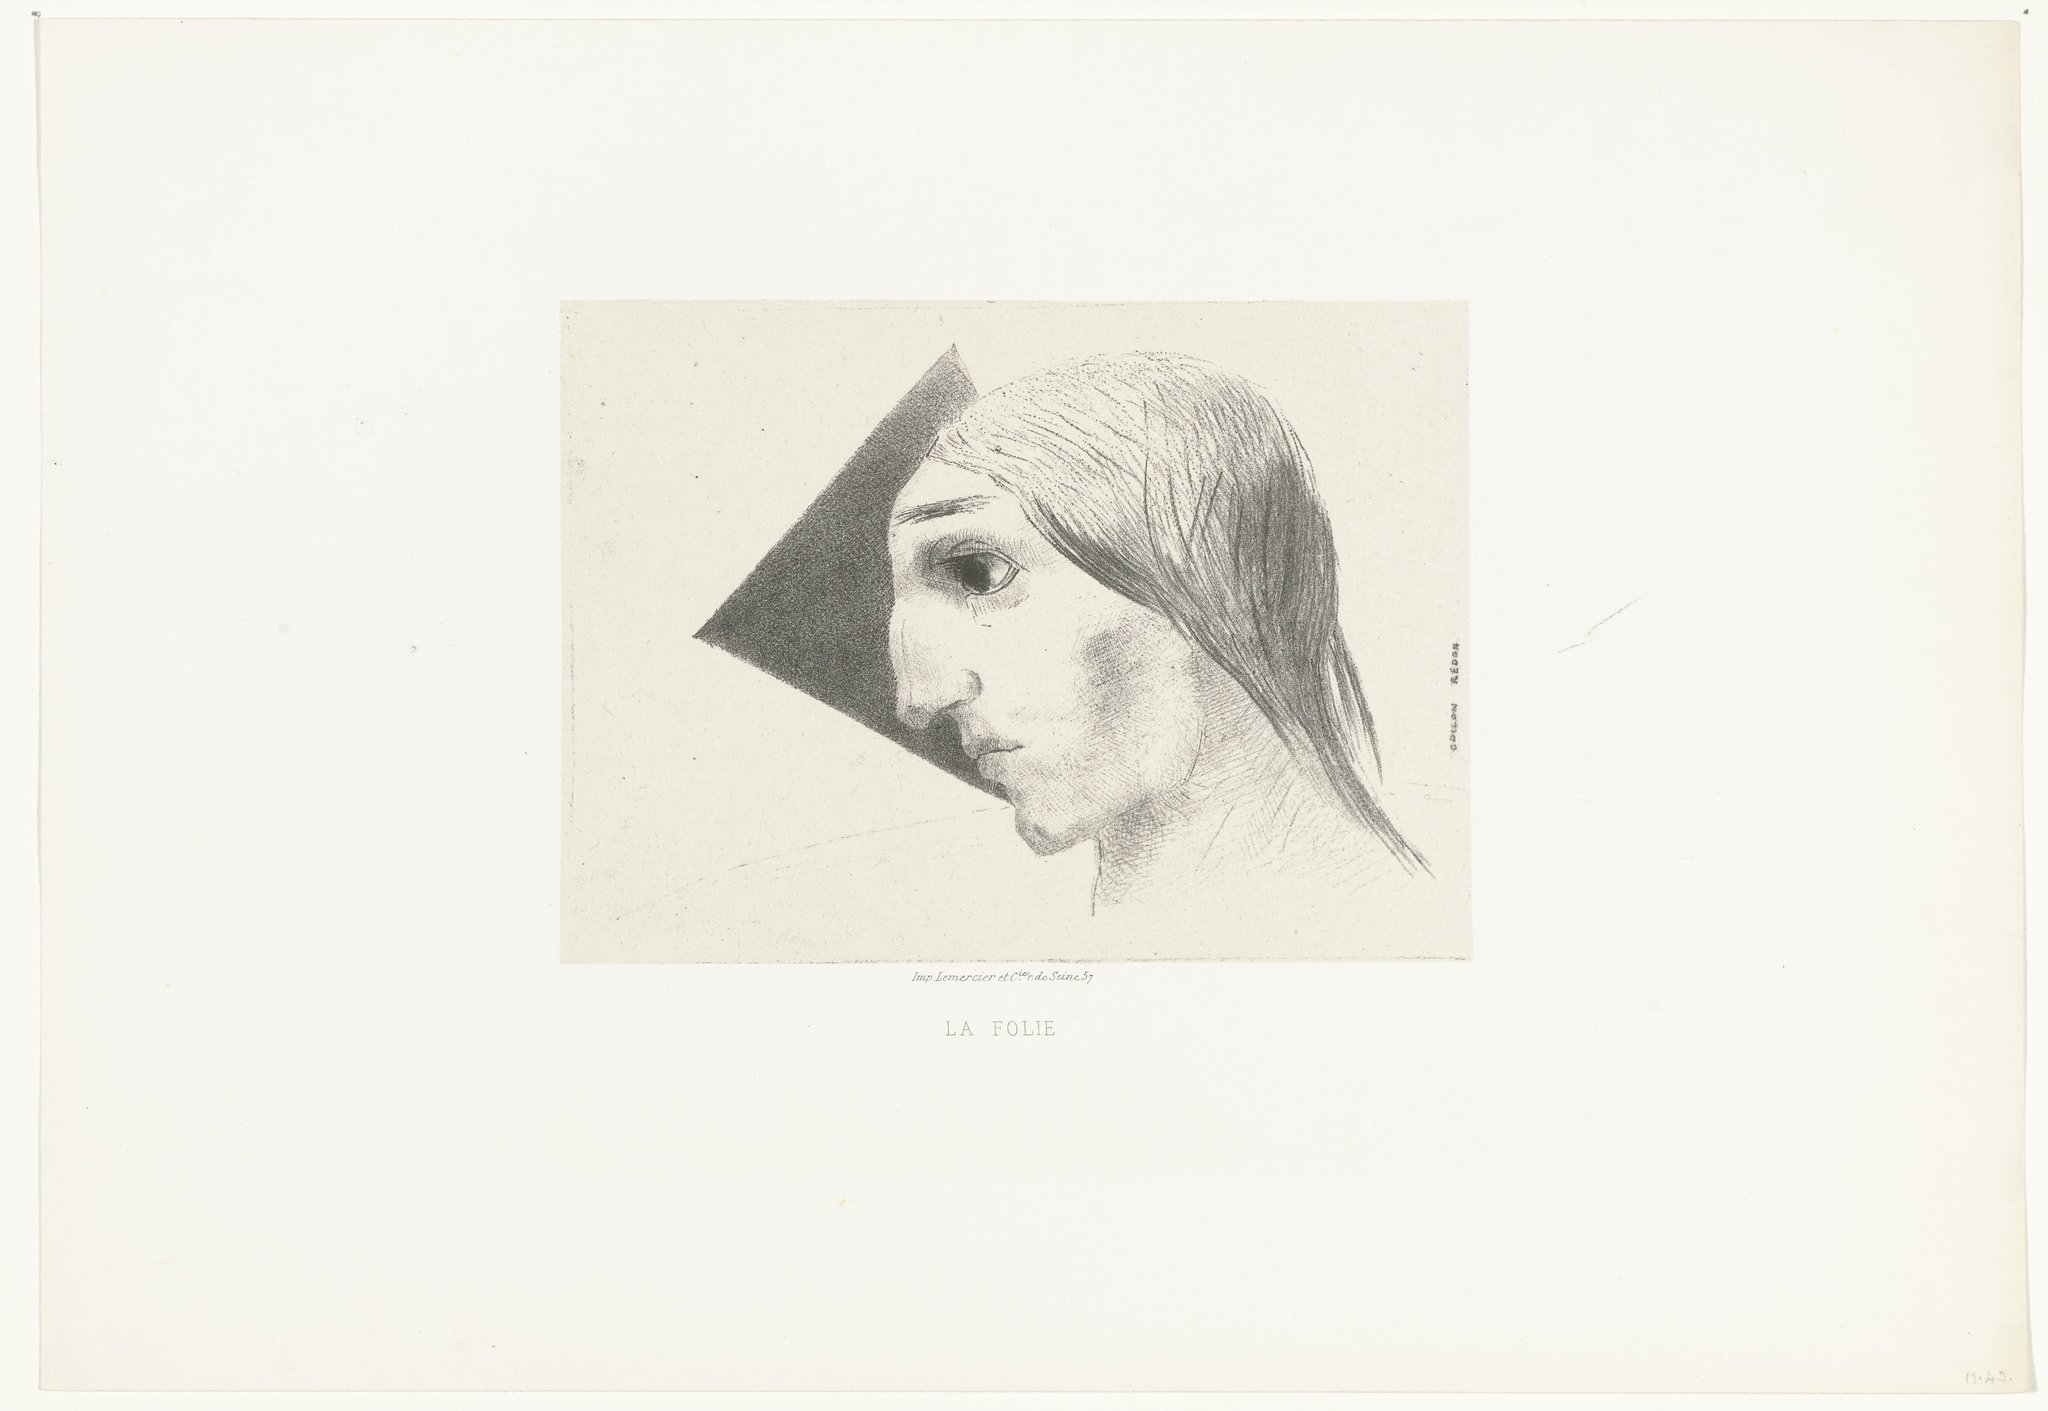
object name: print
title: La Folie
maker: odilon redon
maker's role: draughtsman, painter, print maker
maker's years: 1840-1916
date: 1882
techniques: printmaking, lithograph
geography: paris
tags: head (human)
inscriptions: collector's mark: Lugt 2760, collector's mark: Lugt 2228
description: Hoofd van een man, en profil. Zesde van zes prenten uit het album "A Edgar Poe".